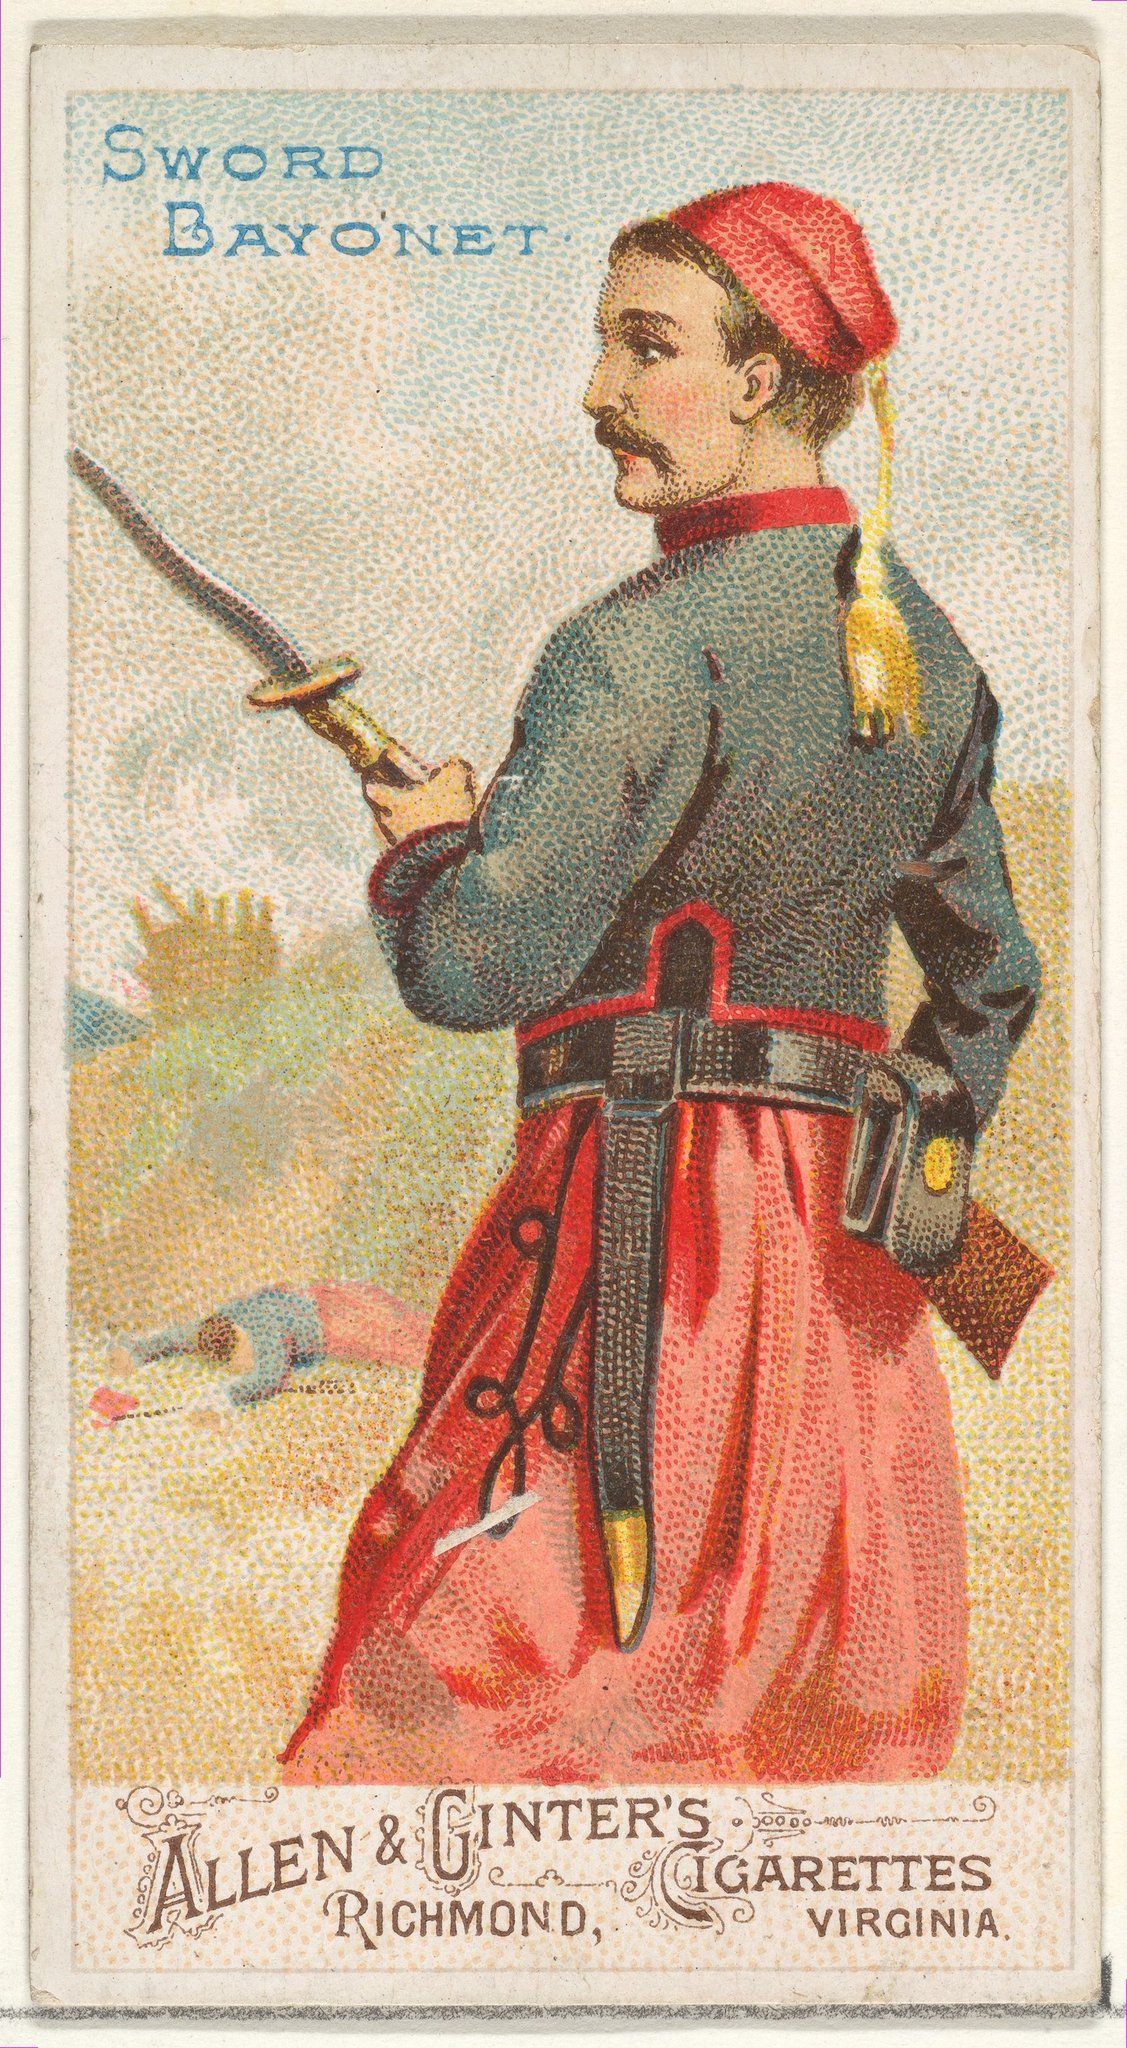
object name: print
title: Sword Bayonet, from the Arms of All Nations series (N3) for Allen & Ginter Cigarettes Brands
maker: allen & ginter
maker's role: publisher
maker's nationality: american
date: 1887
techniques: color lithograph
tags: weapons,men